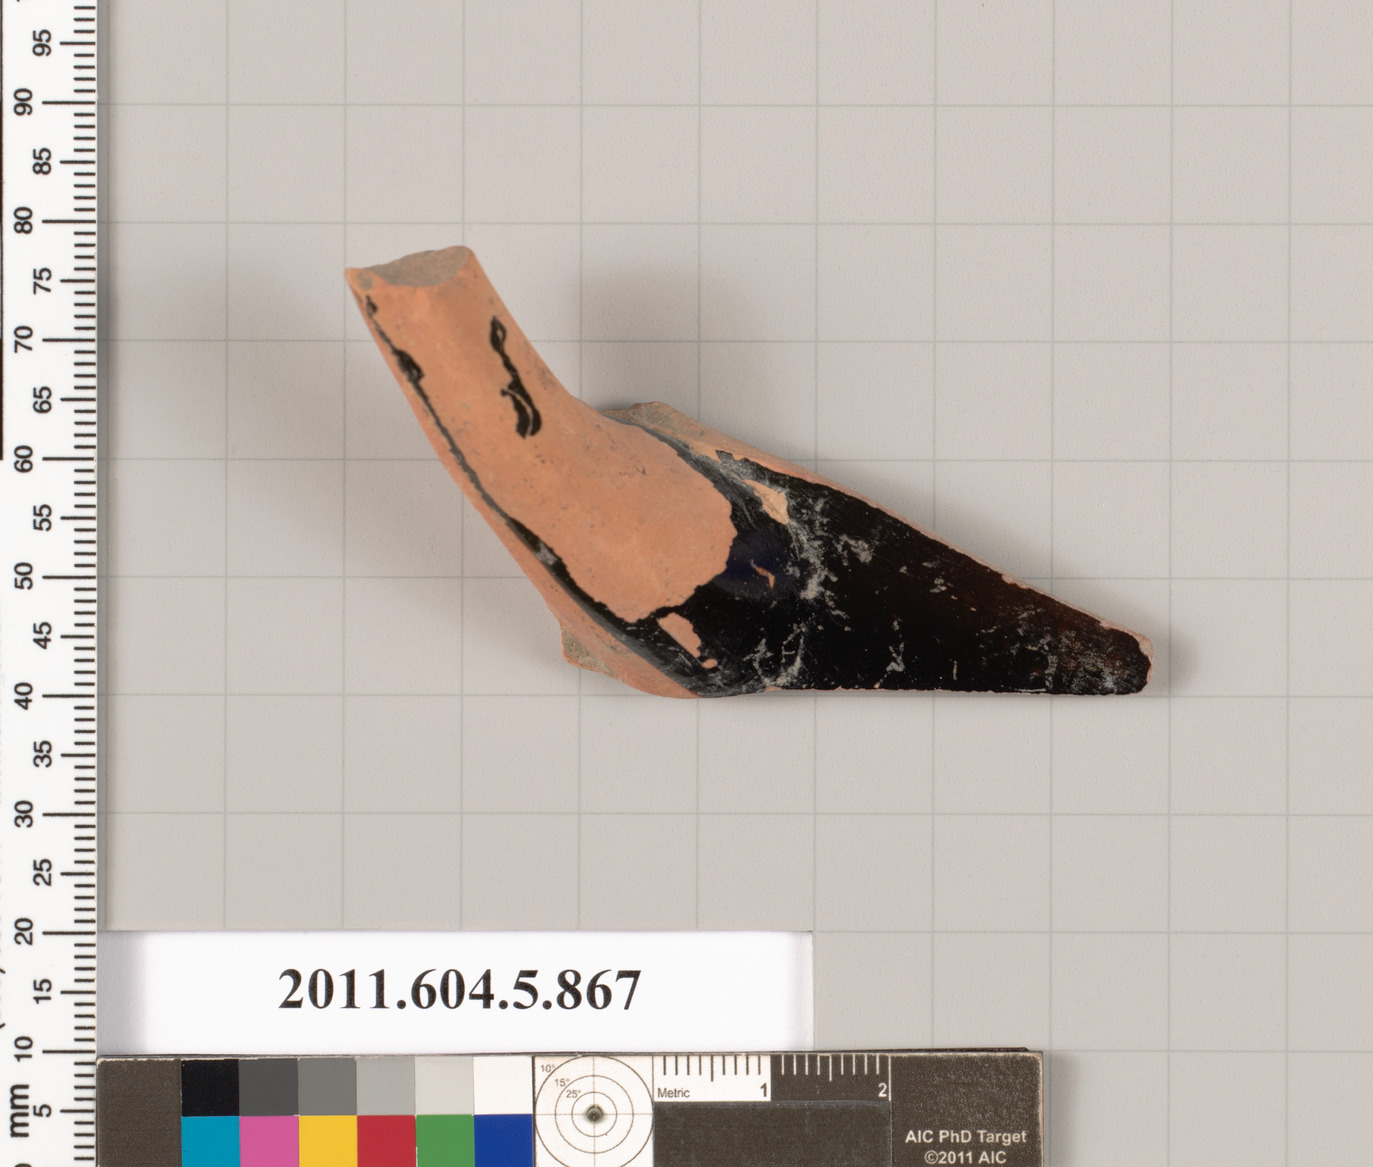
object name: kylix fragment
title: Terracotta fragment of a kylix (drinking cup)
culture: greek, attic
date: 600-401 BCE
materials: terracotta